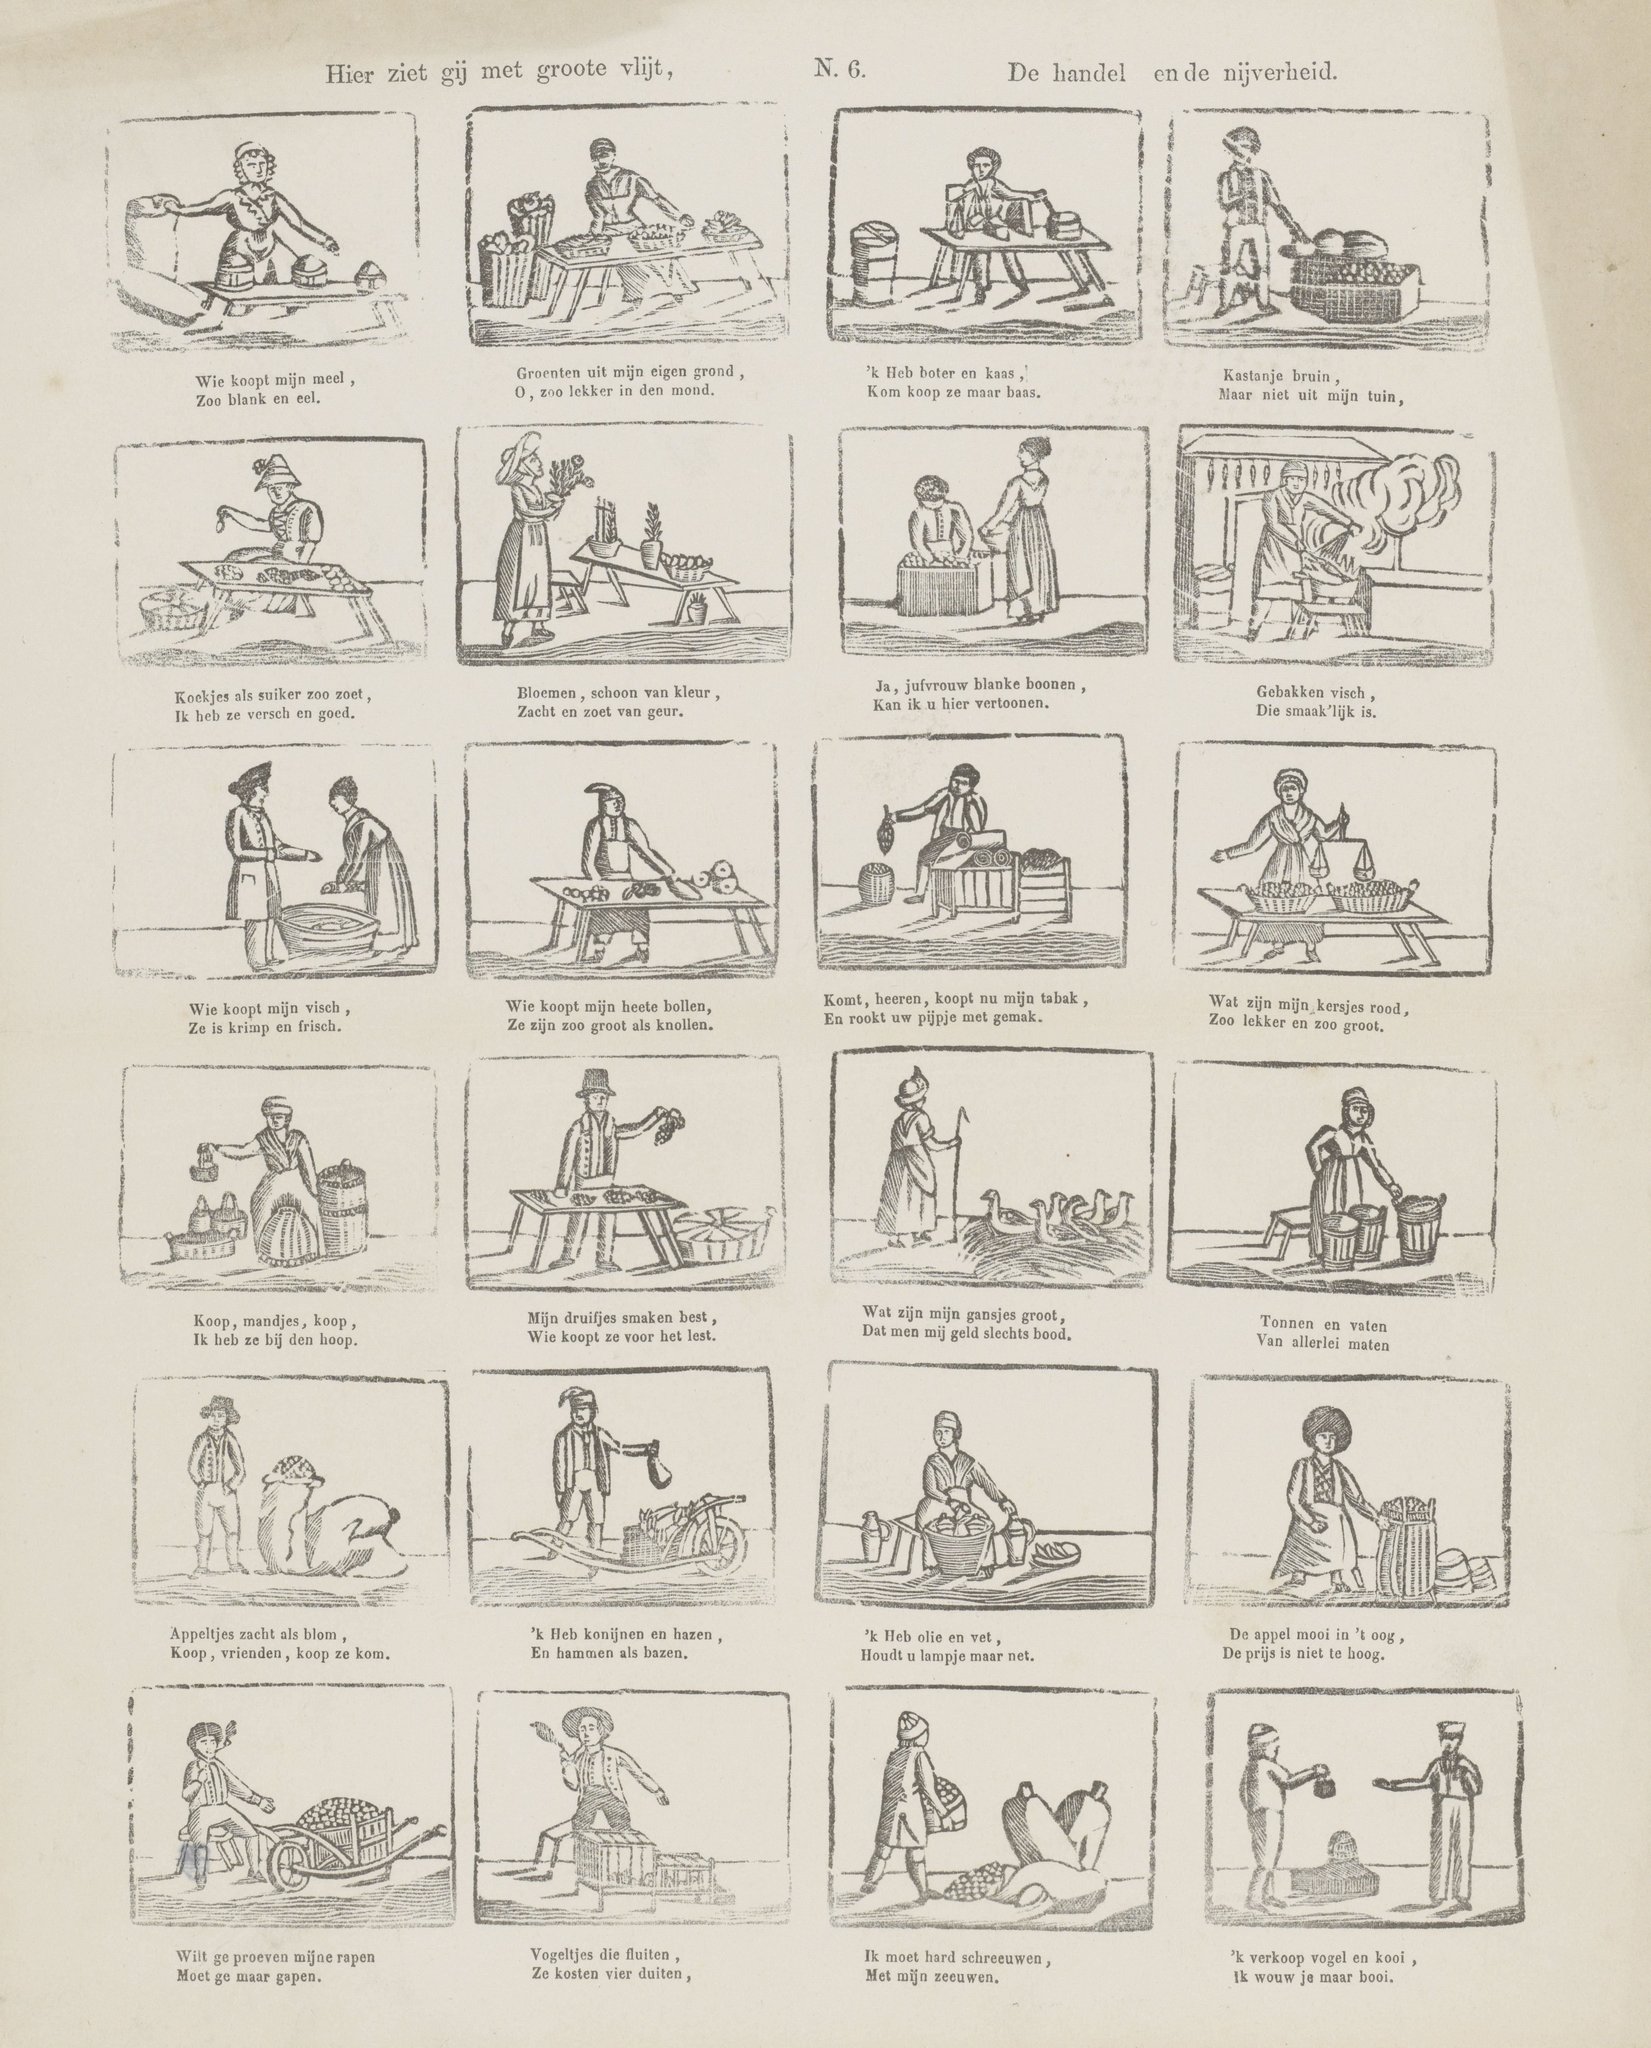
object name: print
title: Hier ziet gij met groote vlijt, / De handel en de nijverheid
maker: Anonymous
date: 1848-1881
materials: paper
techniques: letterpress printing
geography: den bosch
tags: street-trader, merchant, salesman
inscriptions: collector's mark: Lugt 2760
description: Blad met 24 voorstellingen van straatverkopers. Onder elke afbeelding een tweeregelig vers. Genummerd midden boven: N. 6.